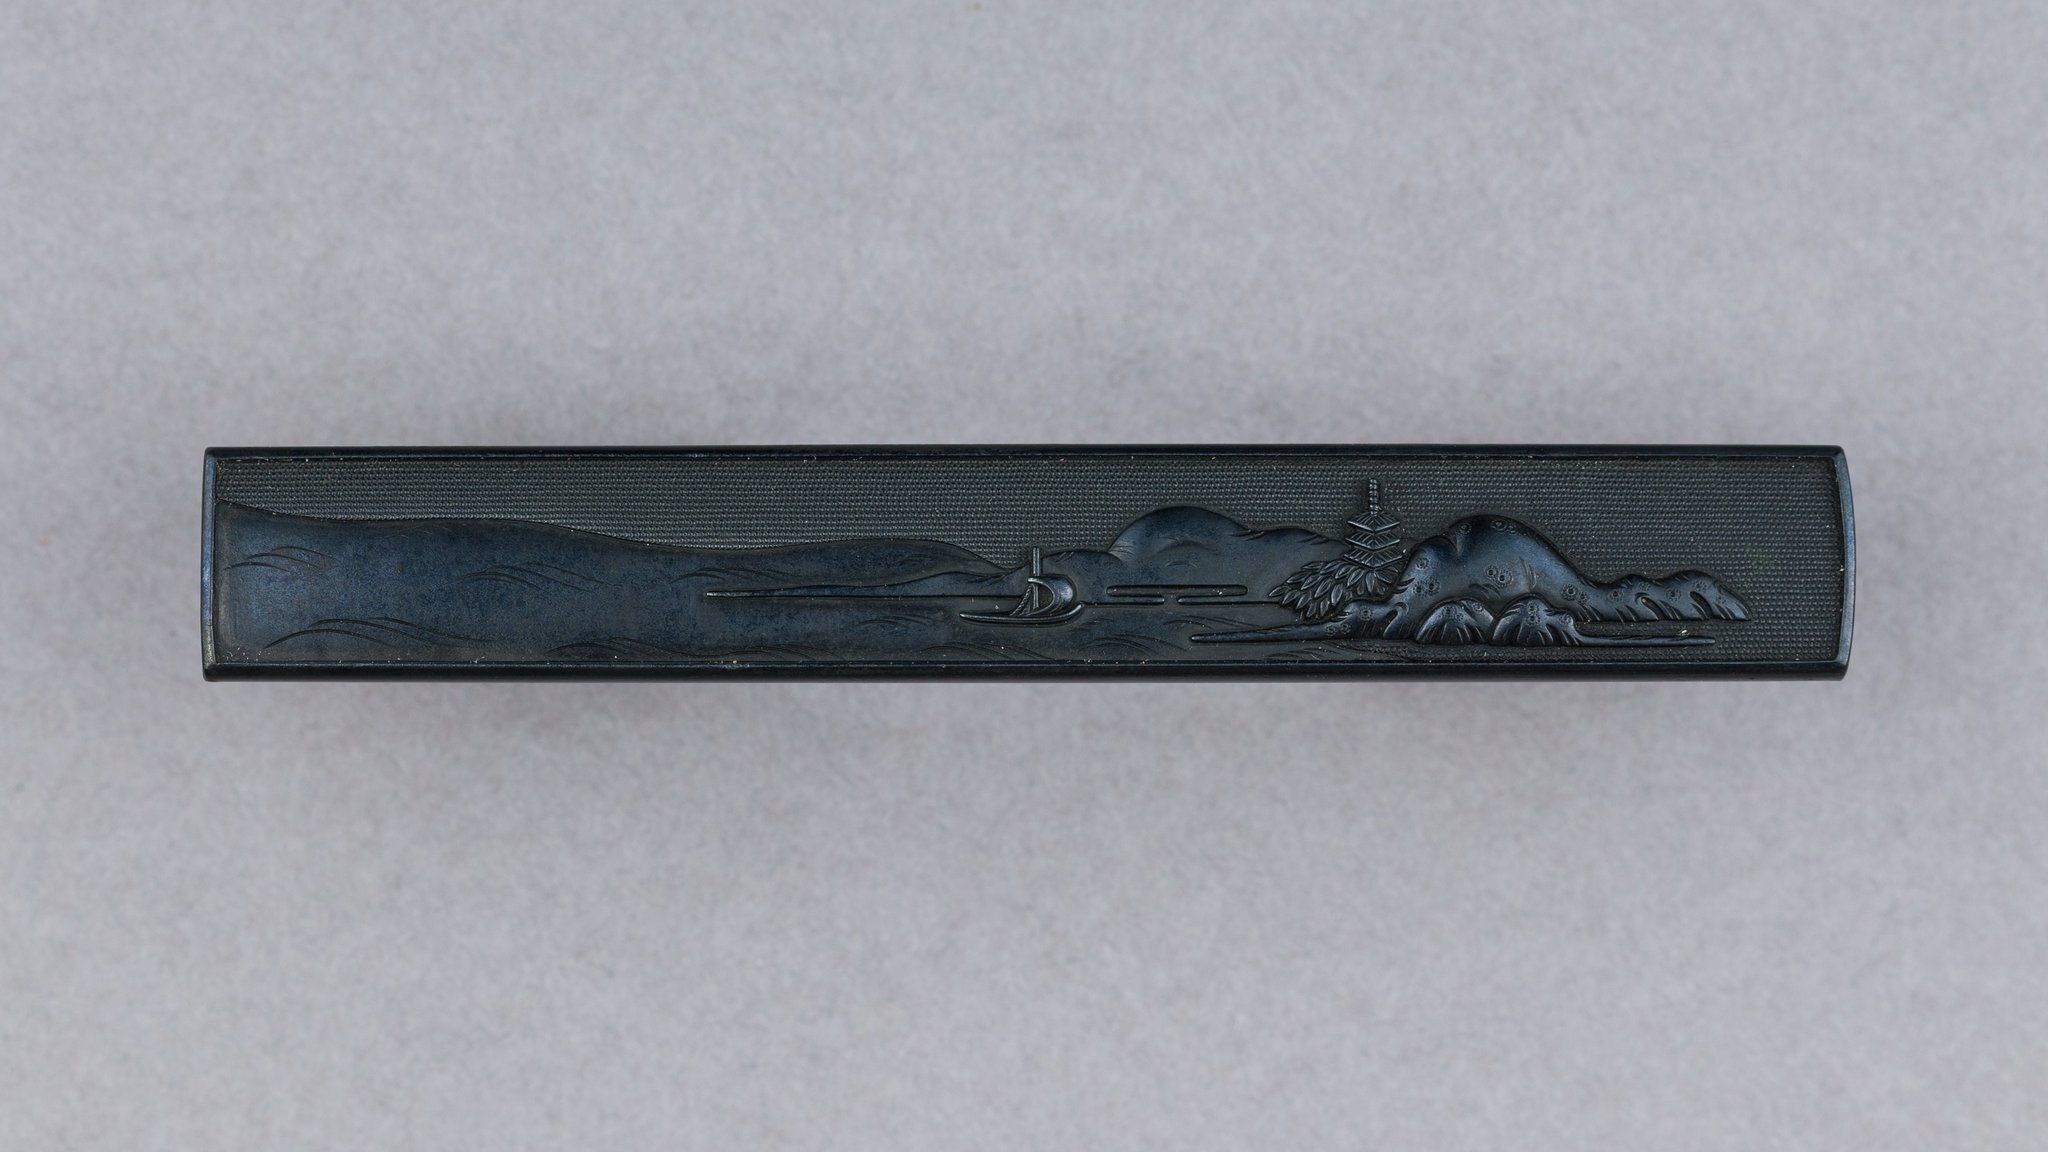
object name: knife handle kozuka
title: Knife Handle (Kozuka)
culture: japanese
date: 1701-1800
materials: gold alloy, gold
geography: japan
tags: landscapes,boats